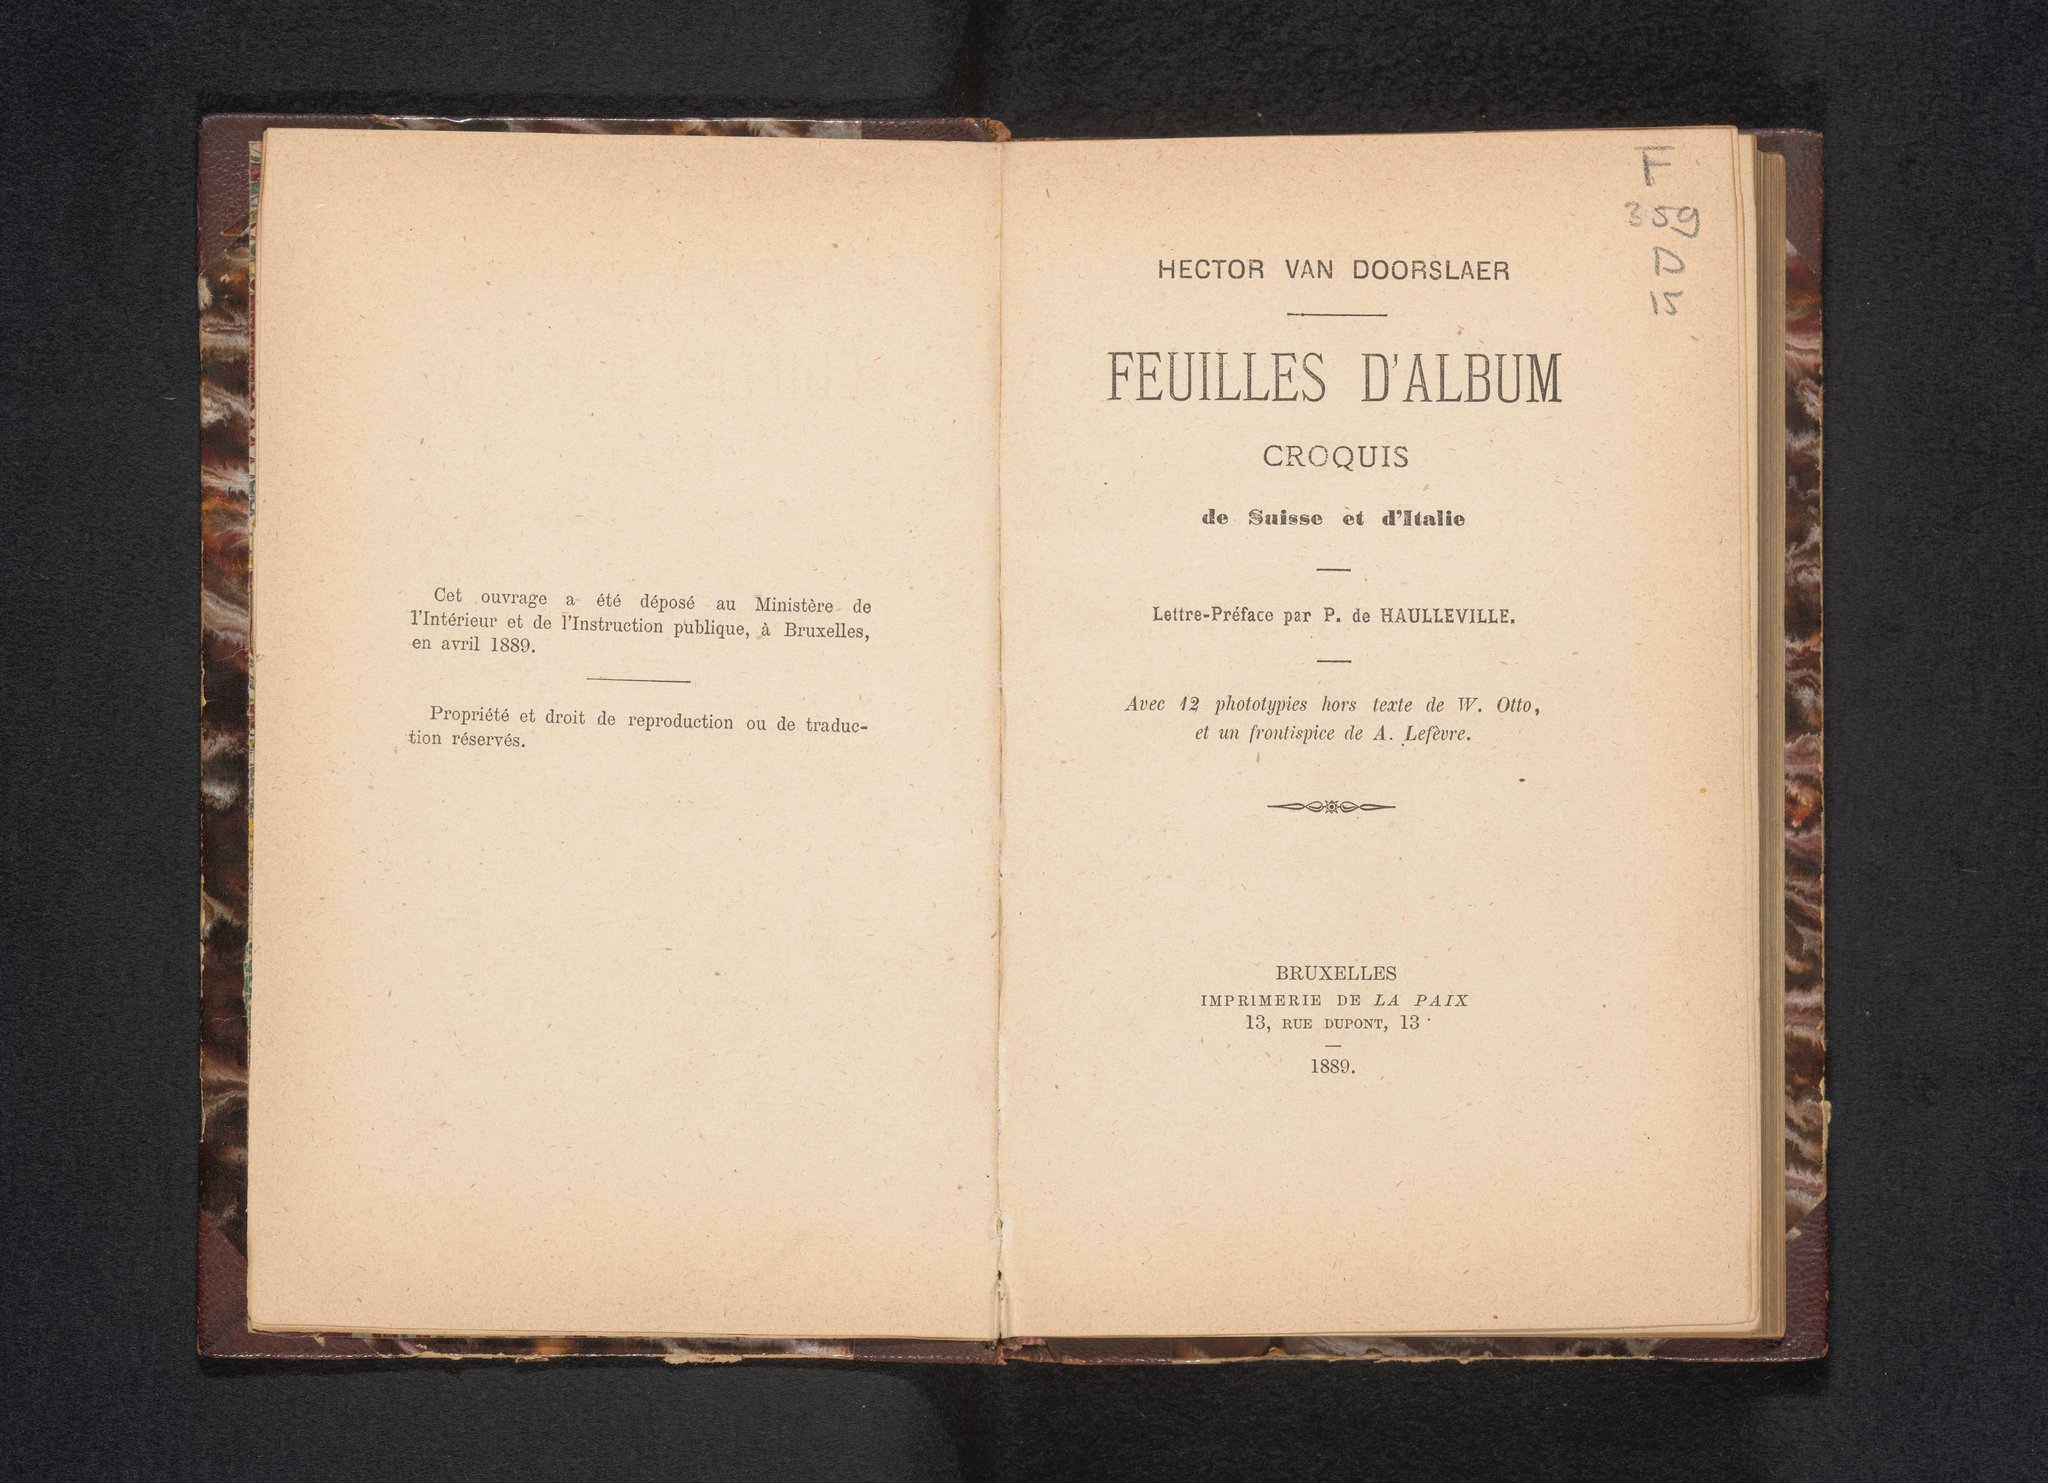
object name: book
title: Feuilles d'album croquis de Suisse et d'Italie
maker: hector van doorslaer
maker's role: schrijver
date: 1889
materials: linen, paper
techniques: photograph, printing, marbled paper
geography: brussels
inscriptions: annotation: ‘1.400-’, date: ‘Apr 2000’